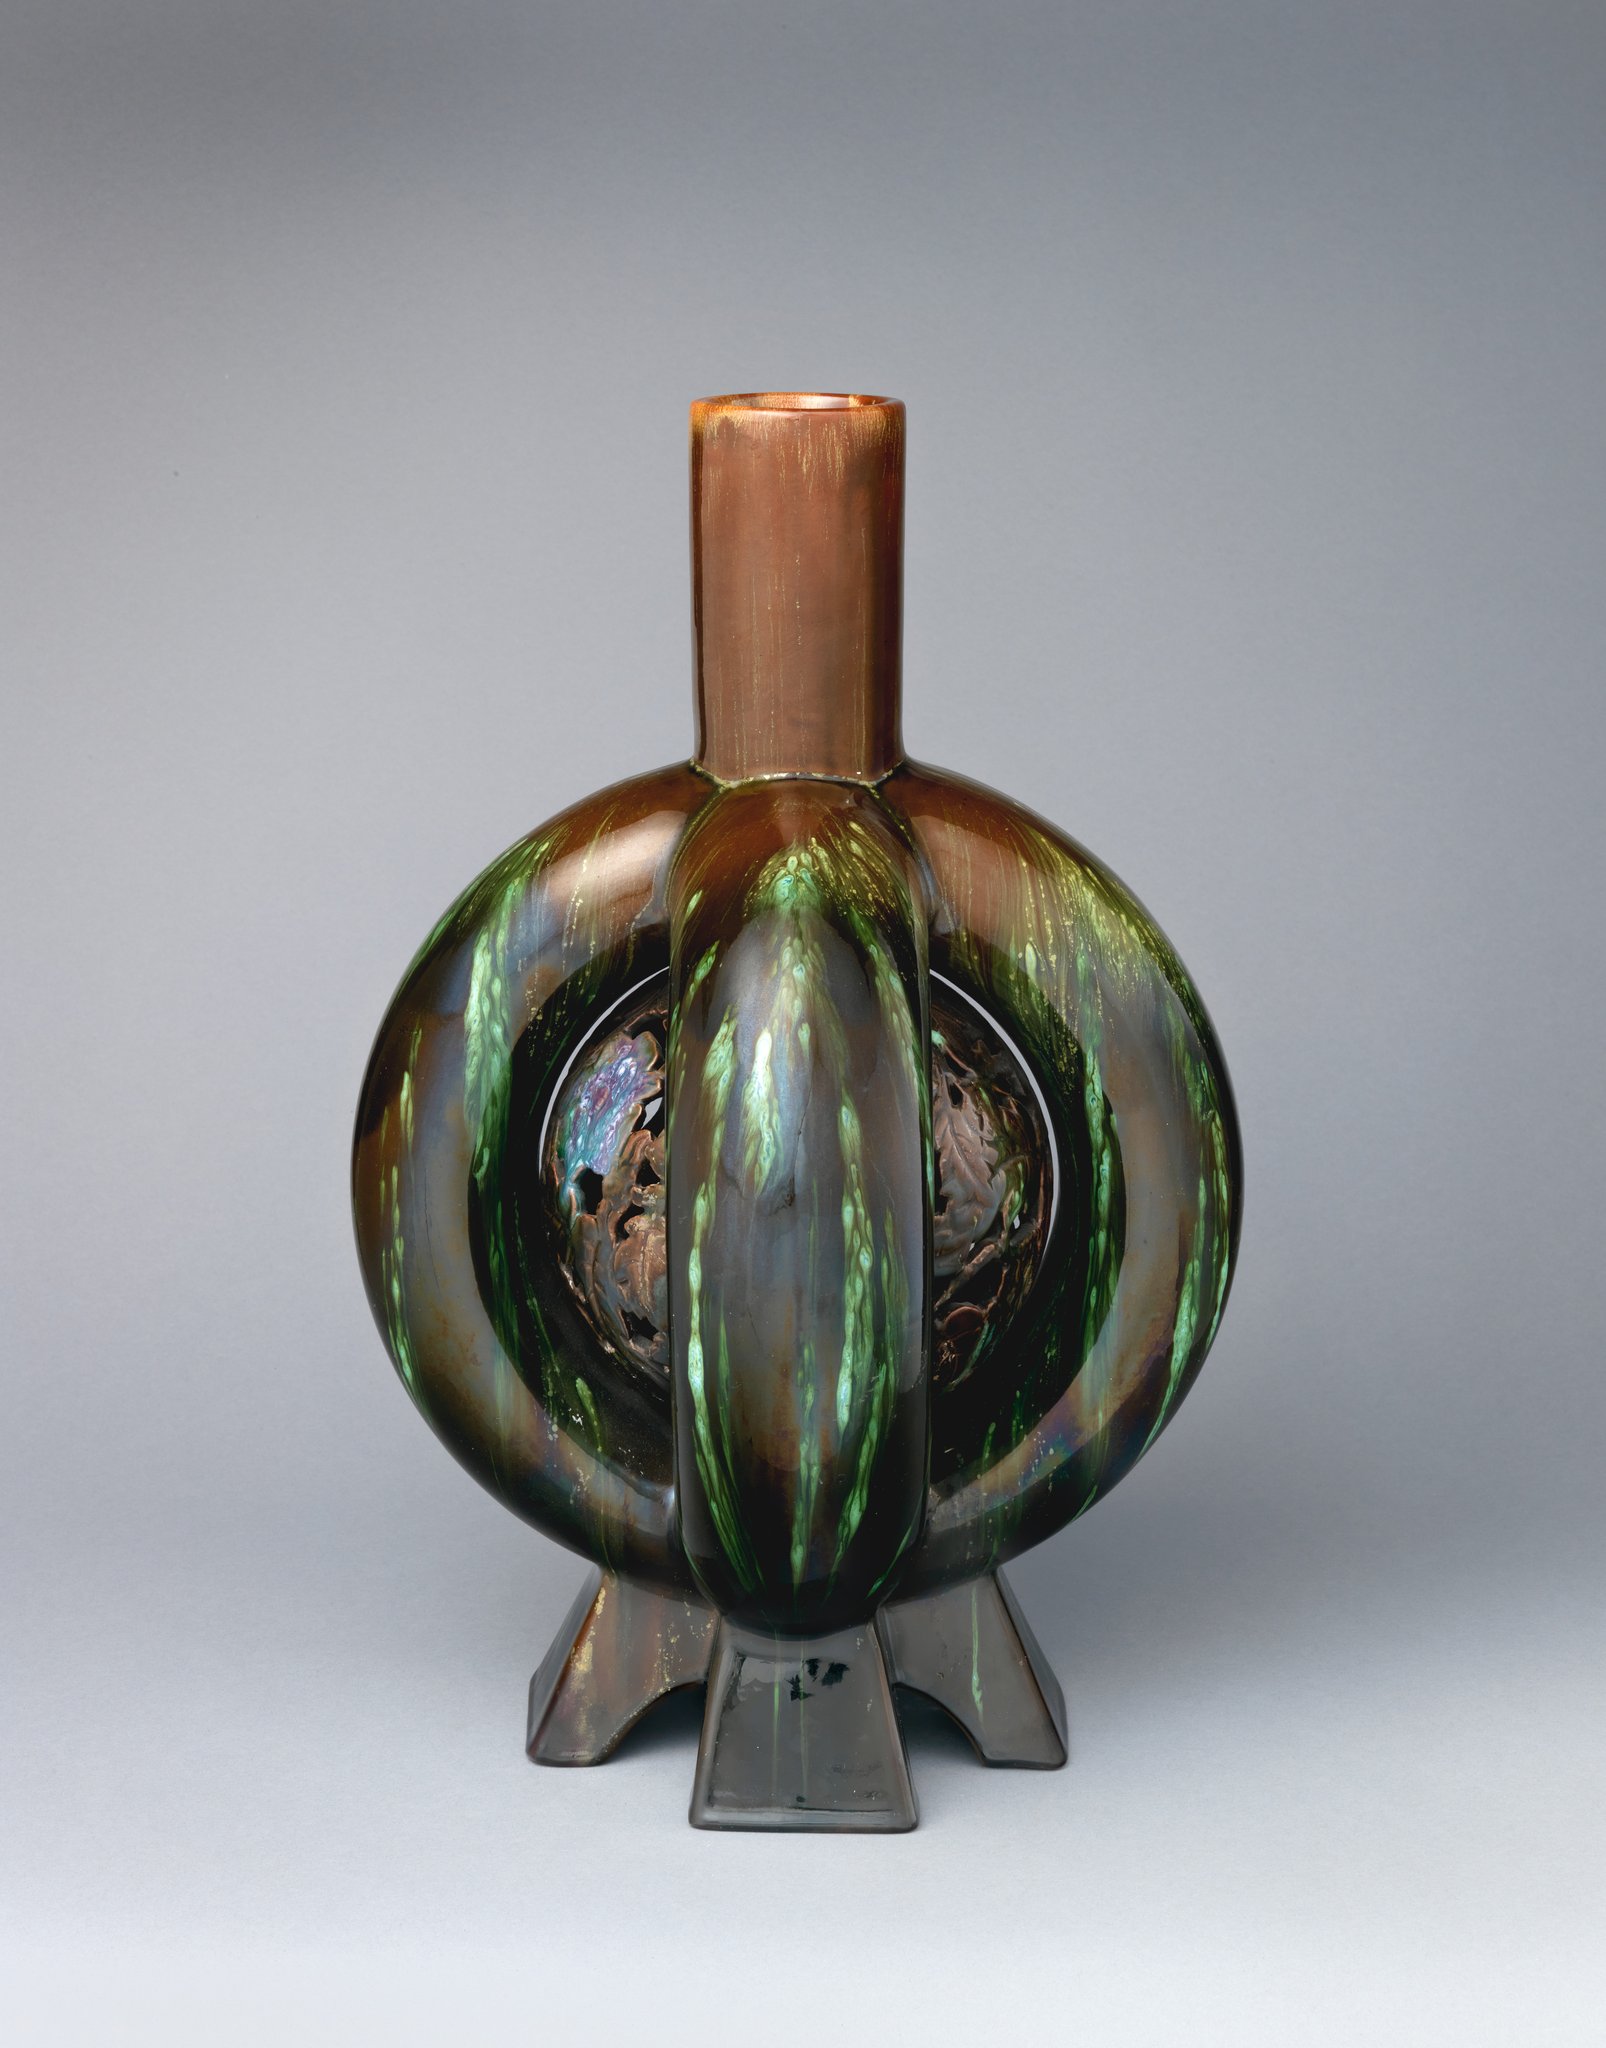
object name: vase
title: Lobed bottle vase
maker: christopher dresser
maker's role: designer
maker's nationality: british, scottish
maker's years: 1834-1904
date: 1880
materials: earthenware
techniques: glazing